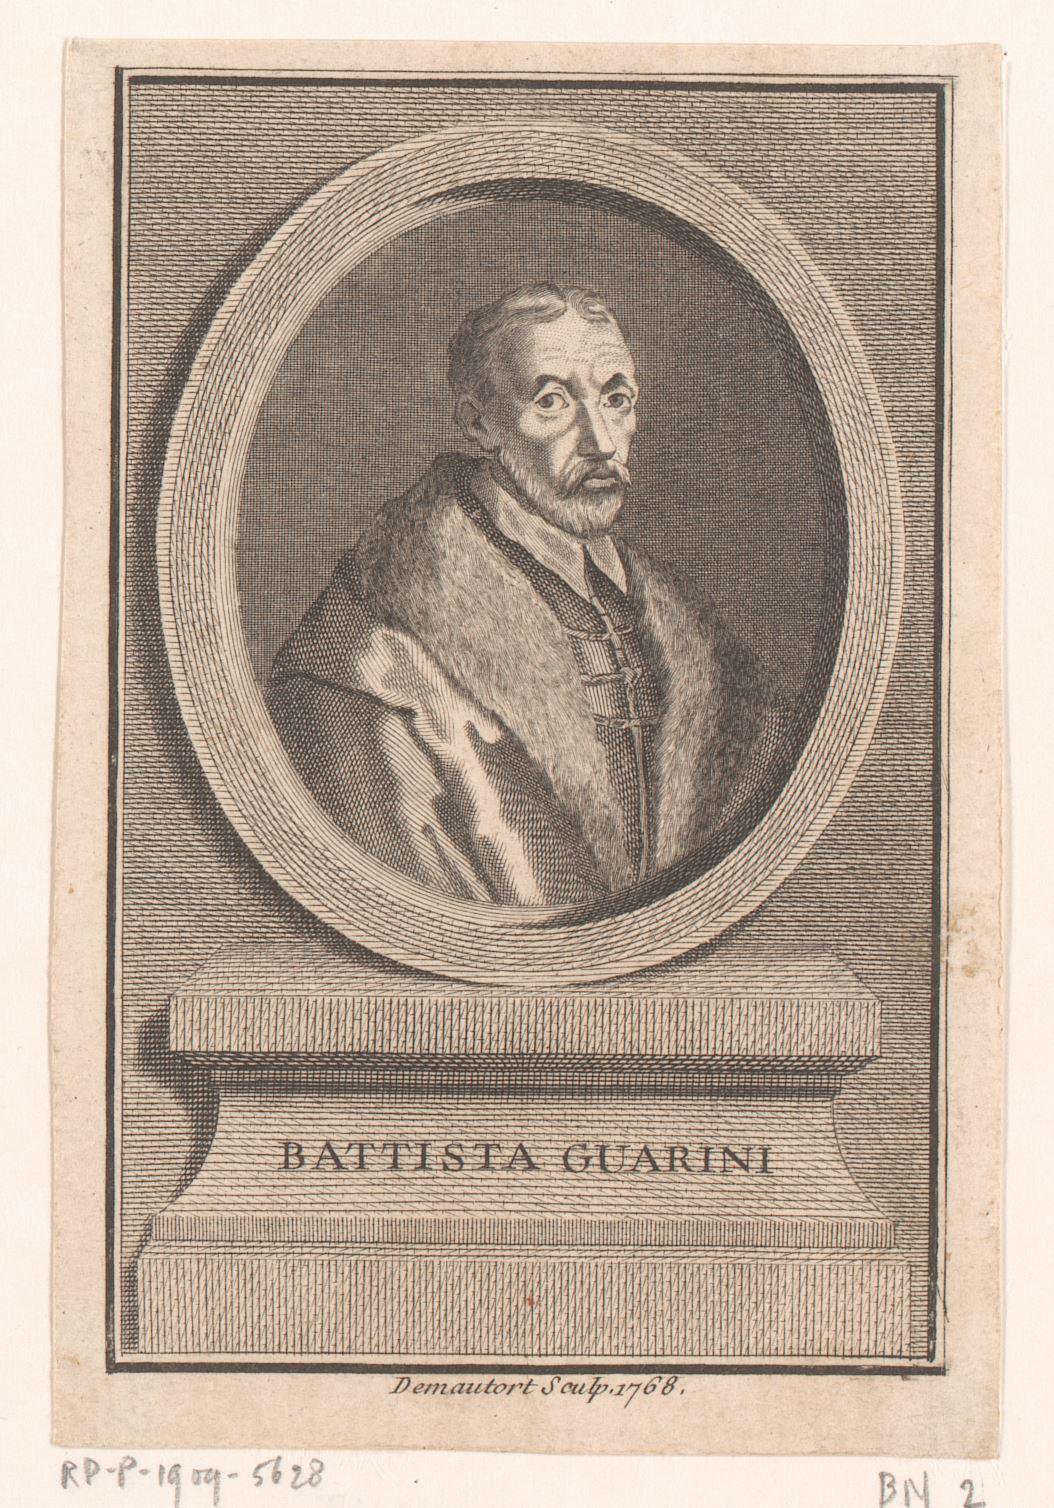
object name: print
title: Portret van Giovanni Battista Guarini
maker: demautort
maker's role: print maker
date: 1768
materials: paper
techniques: engraving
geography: france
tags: venice, historical persons, portrait of a writer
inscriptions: collector's mark: Lugt 2228